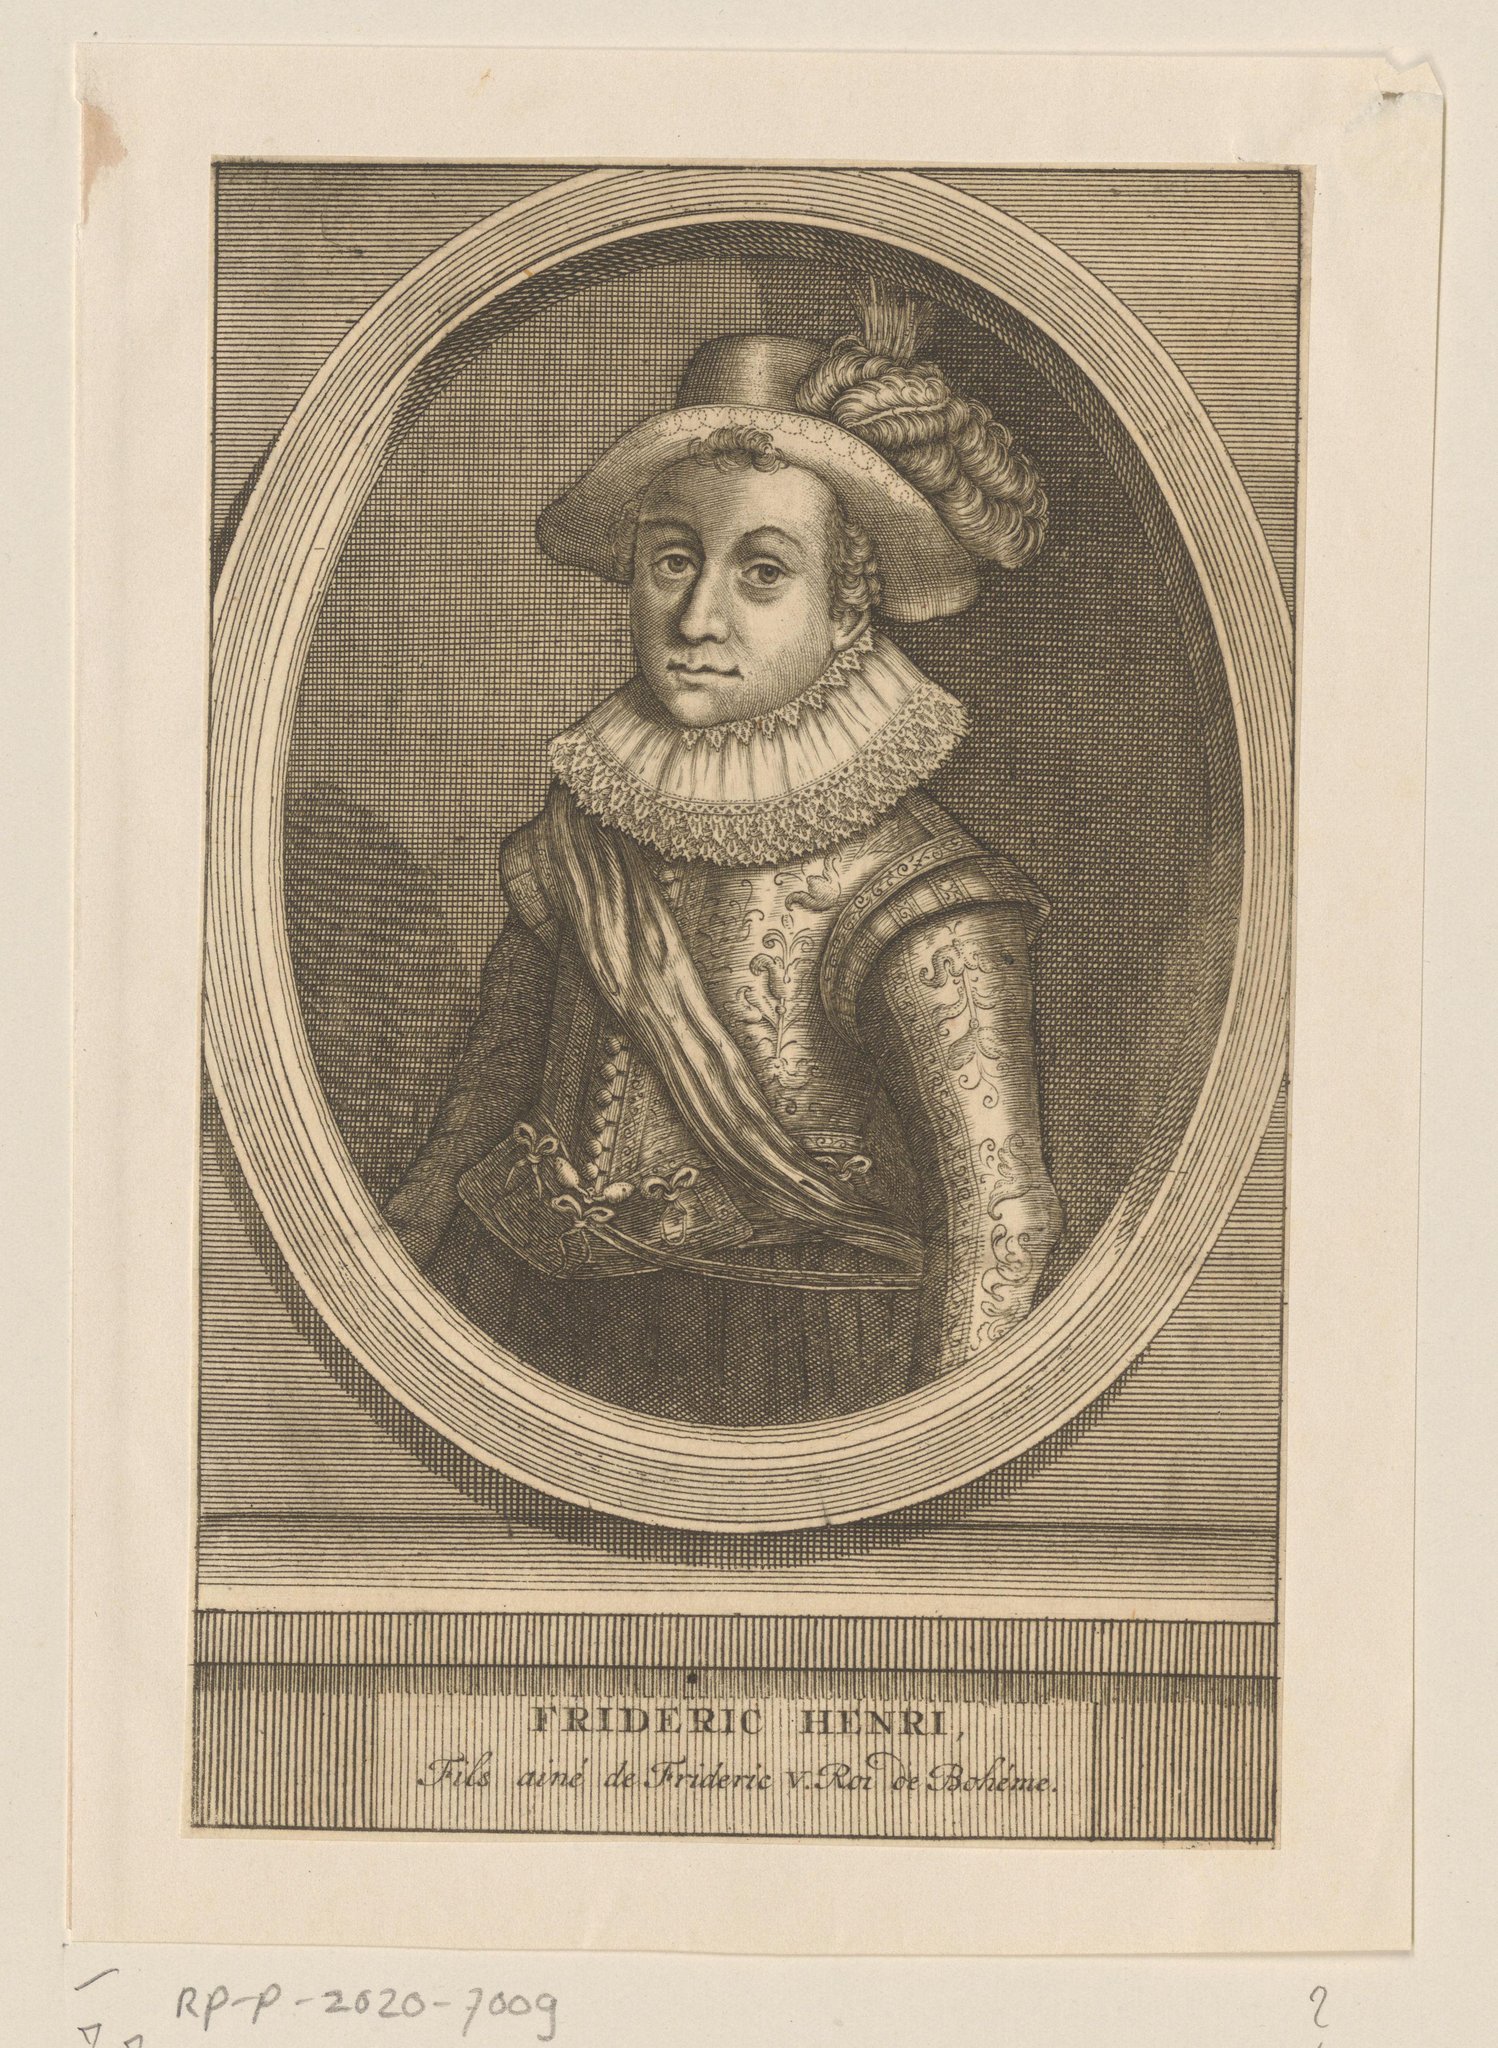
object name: print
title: Portret van Frederik Hendrik van de Palts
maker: Anonymous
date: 1650-1750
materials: paper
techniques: engraving, etching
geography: france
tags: prince, historical persons, neck-gear: collar (+ lace used for clothes)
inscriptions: inscription: ‘Hij verloor ongelukkig het leven op/ het Haarlemmer-meer, worden het schip/ in het welk hij met zijnen Vader naar/ Amsterdam toog, ten Jare 1629 (...) Zie J. Wagenaar. Vaderl. Hist. D. XI:/ bl. 112 en bijvoegs.’